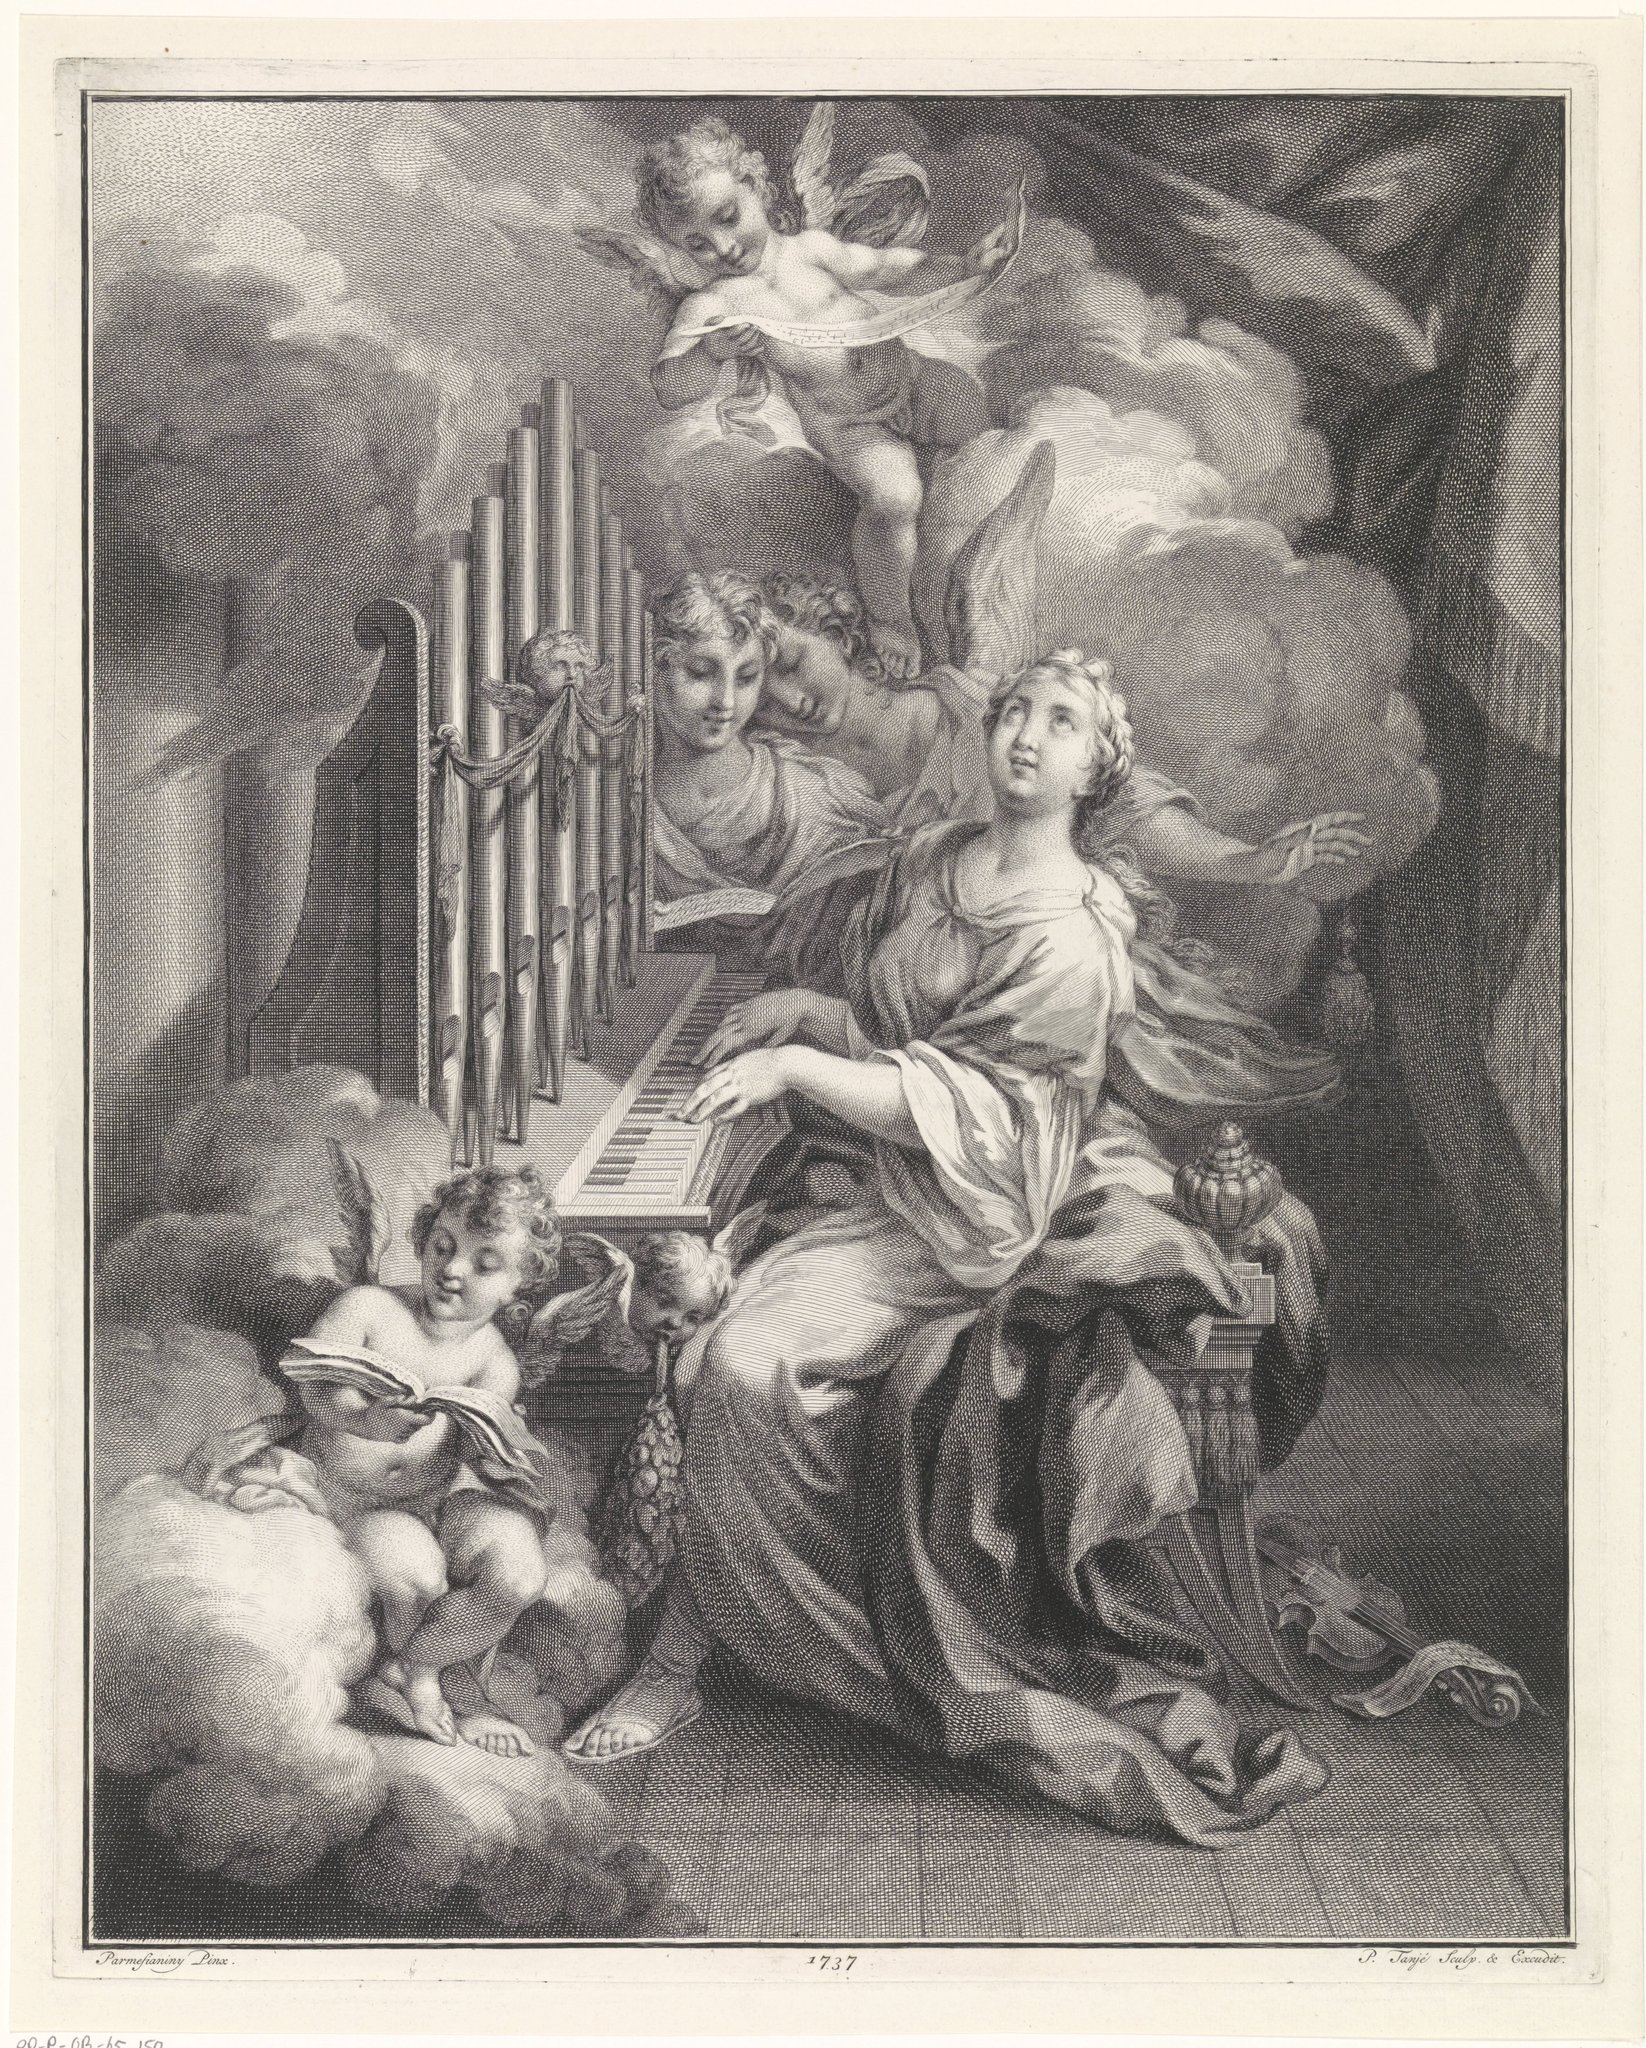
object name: print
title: H. Cecilia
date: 1737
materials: paper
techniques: engraving, etching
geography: amsterdam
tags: angels singing, making music, st. cecilia making music and/or singing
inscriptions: collector's mark: Lugt 240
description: De heilige Cecilia als patroonheilige van de muziek. Zij bespeelt het orgel omringt door zingende engelen. Op de grond ligt een viool.